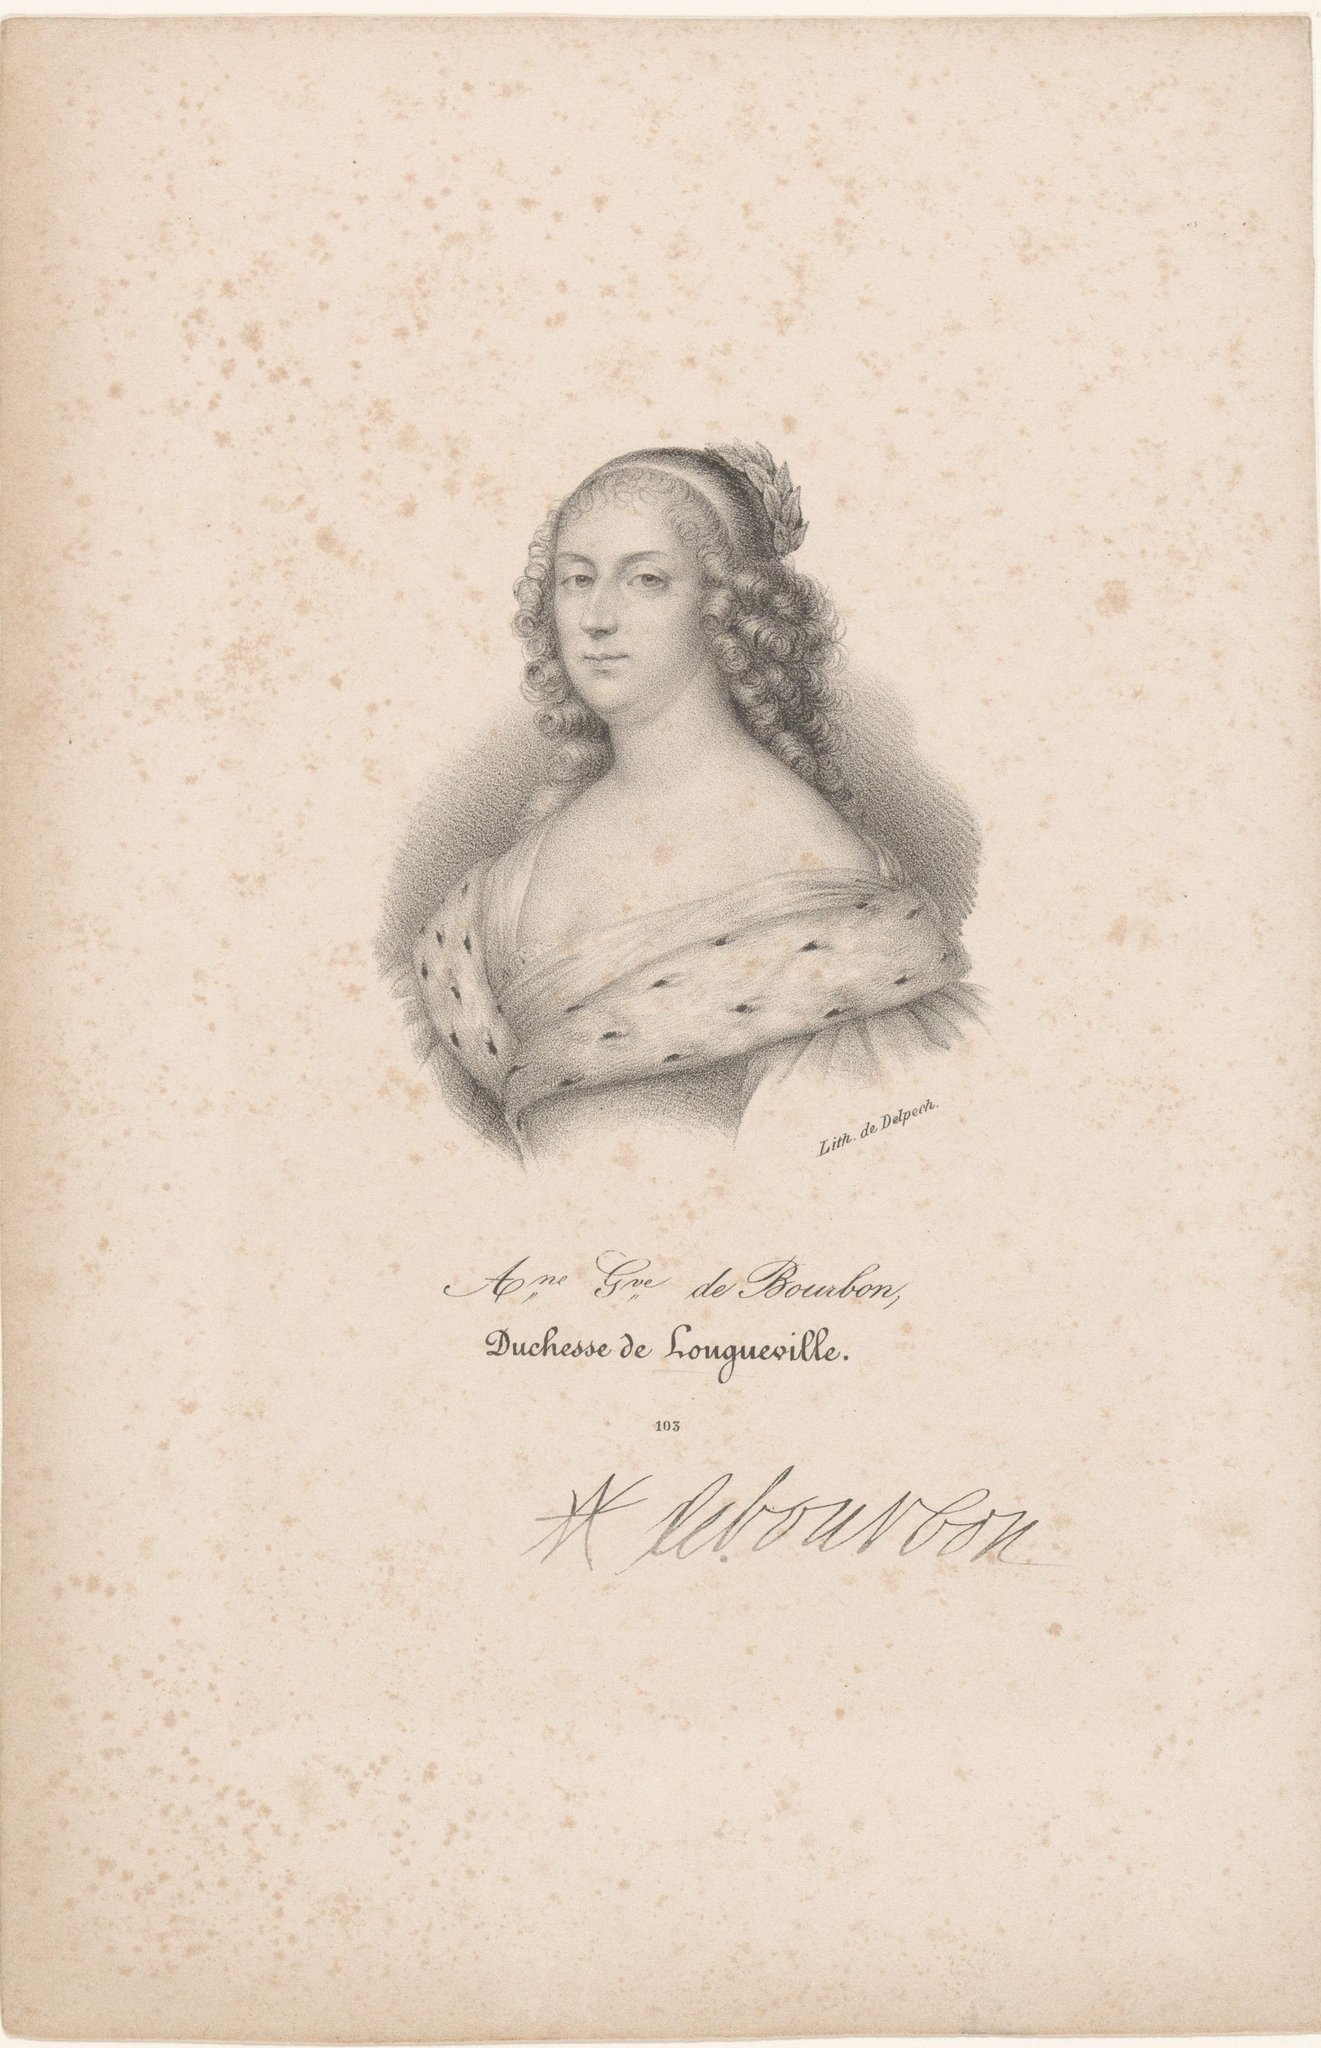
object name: print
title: A.ne G.ve de Bourbon, duchesse de Longueville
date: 1818-1842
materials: paper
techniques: lithograph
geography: paris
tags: paris, anna genoveva van bourbon-condé, historical persons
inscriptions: collector's mark: Lugt 2228a